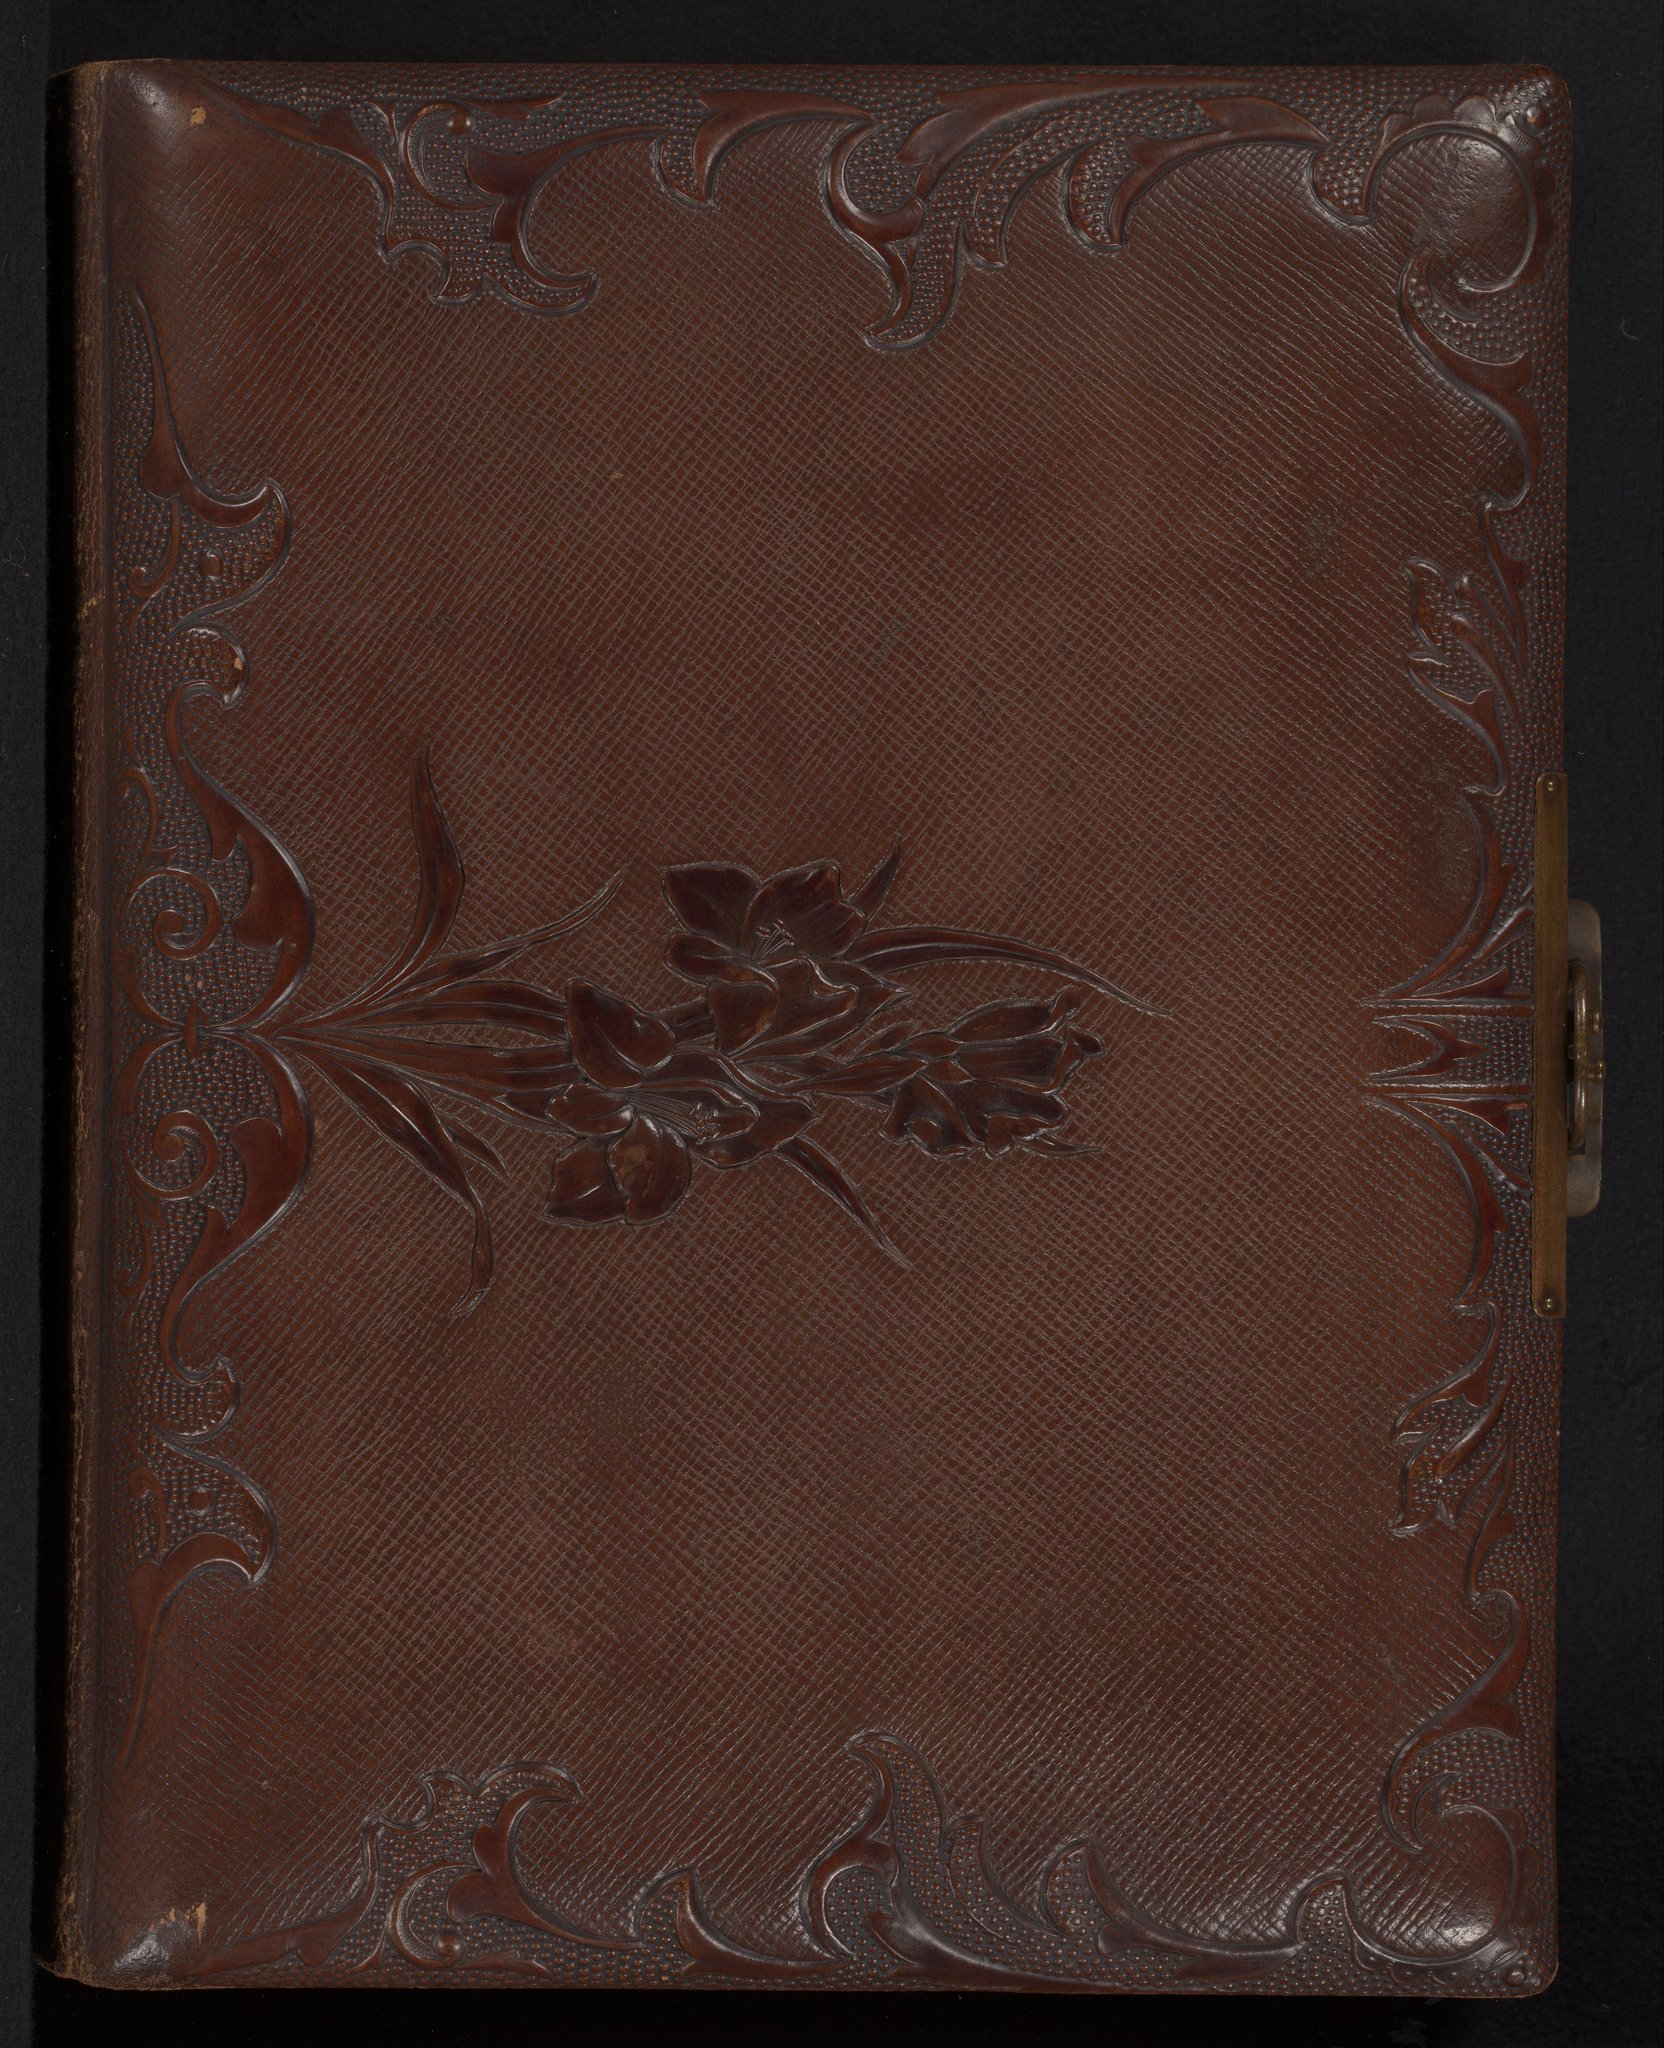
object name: slip in album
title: Nederlands familiealbum van de familie Roos met 73 foto's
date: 1860-1900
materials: cardboard, leather, metal, paper, photographic support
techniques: albumen print, decorated paper, gelatin silver print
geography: netherlands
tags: utrecht, adolescent, young woman, maiden, historical persons - bb - woman, child, historical persons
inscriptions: collector's mark: ‘DIENST/ VERSPREIDE/ RIJKSKOLLEKTIES/ (...) A 826’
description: Fotoalbum met in totaal 73 foto's op 32 pagina's. Het album bevat 16 kabinetfoto's en 57 cartes-de-visite in met gouden lijnen omkaderde passe-partouts. Afgebeeld zijn portretten van leden en vrienden van de familie Roos, vermoedelijk uit Amsterdam. Enkele geportretteerden zijn bij naam bekend, waaronder Coba Roos, Frans Reijk Roos senior en junior en Cootje en Tootje Roos. De foto's zijn gemaakt door verschillende Nederlandse fotografen, waaronder Cornelis Johannes Lodewicus Vermeulen (11), Max Cosman (7) en Albert Greiner (6). Van 5 foto's is de fotograaf anoniem.